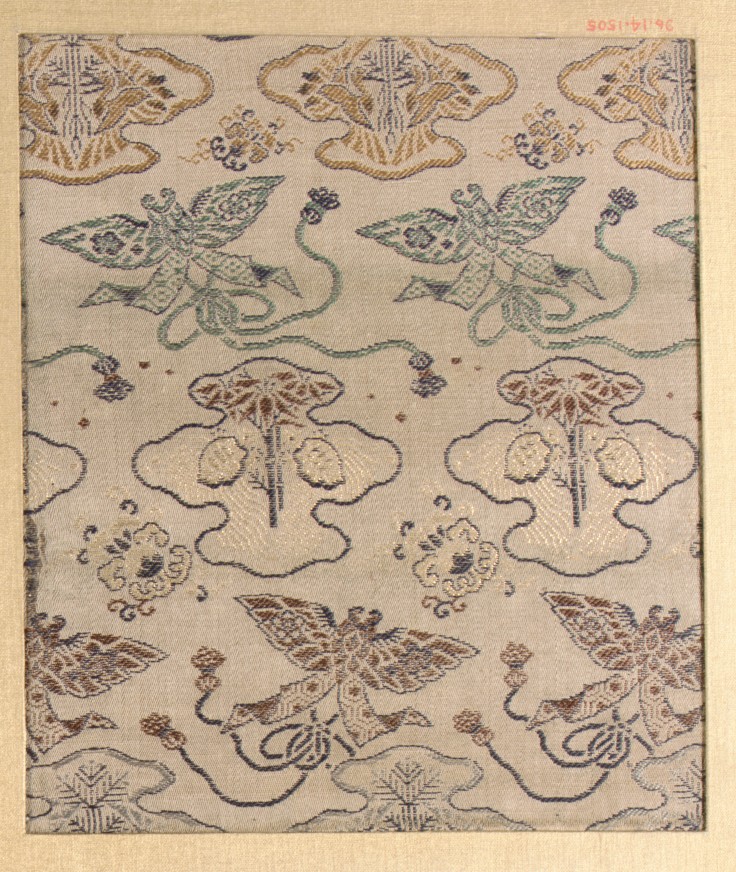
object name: piece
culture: japanese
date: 1701-1900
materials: silk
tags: butterflies